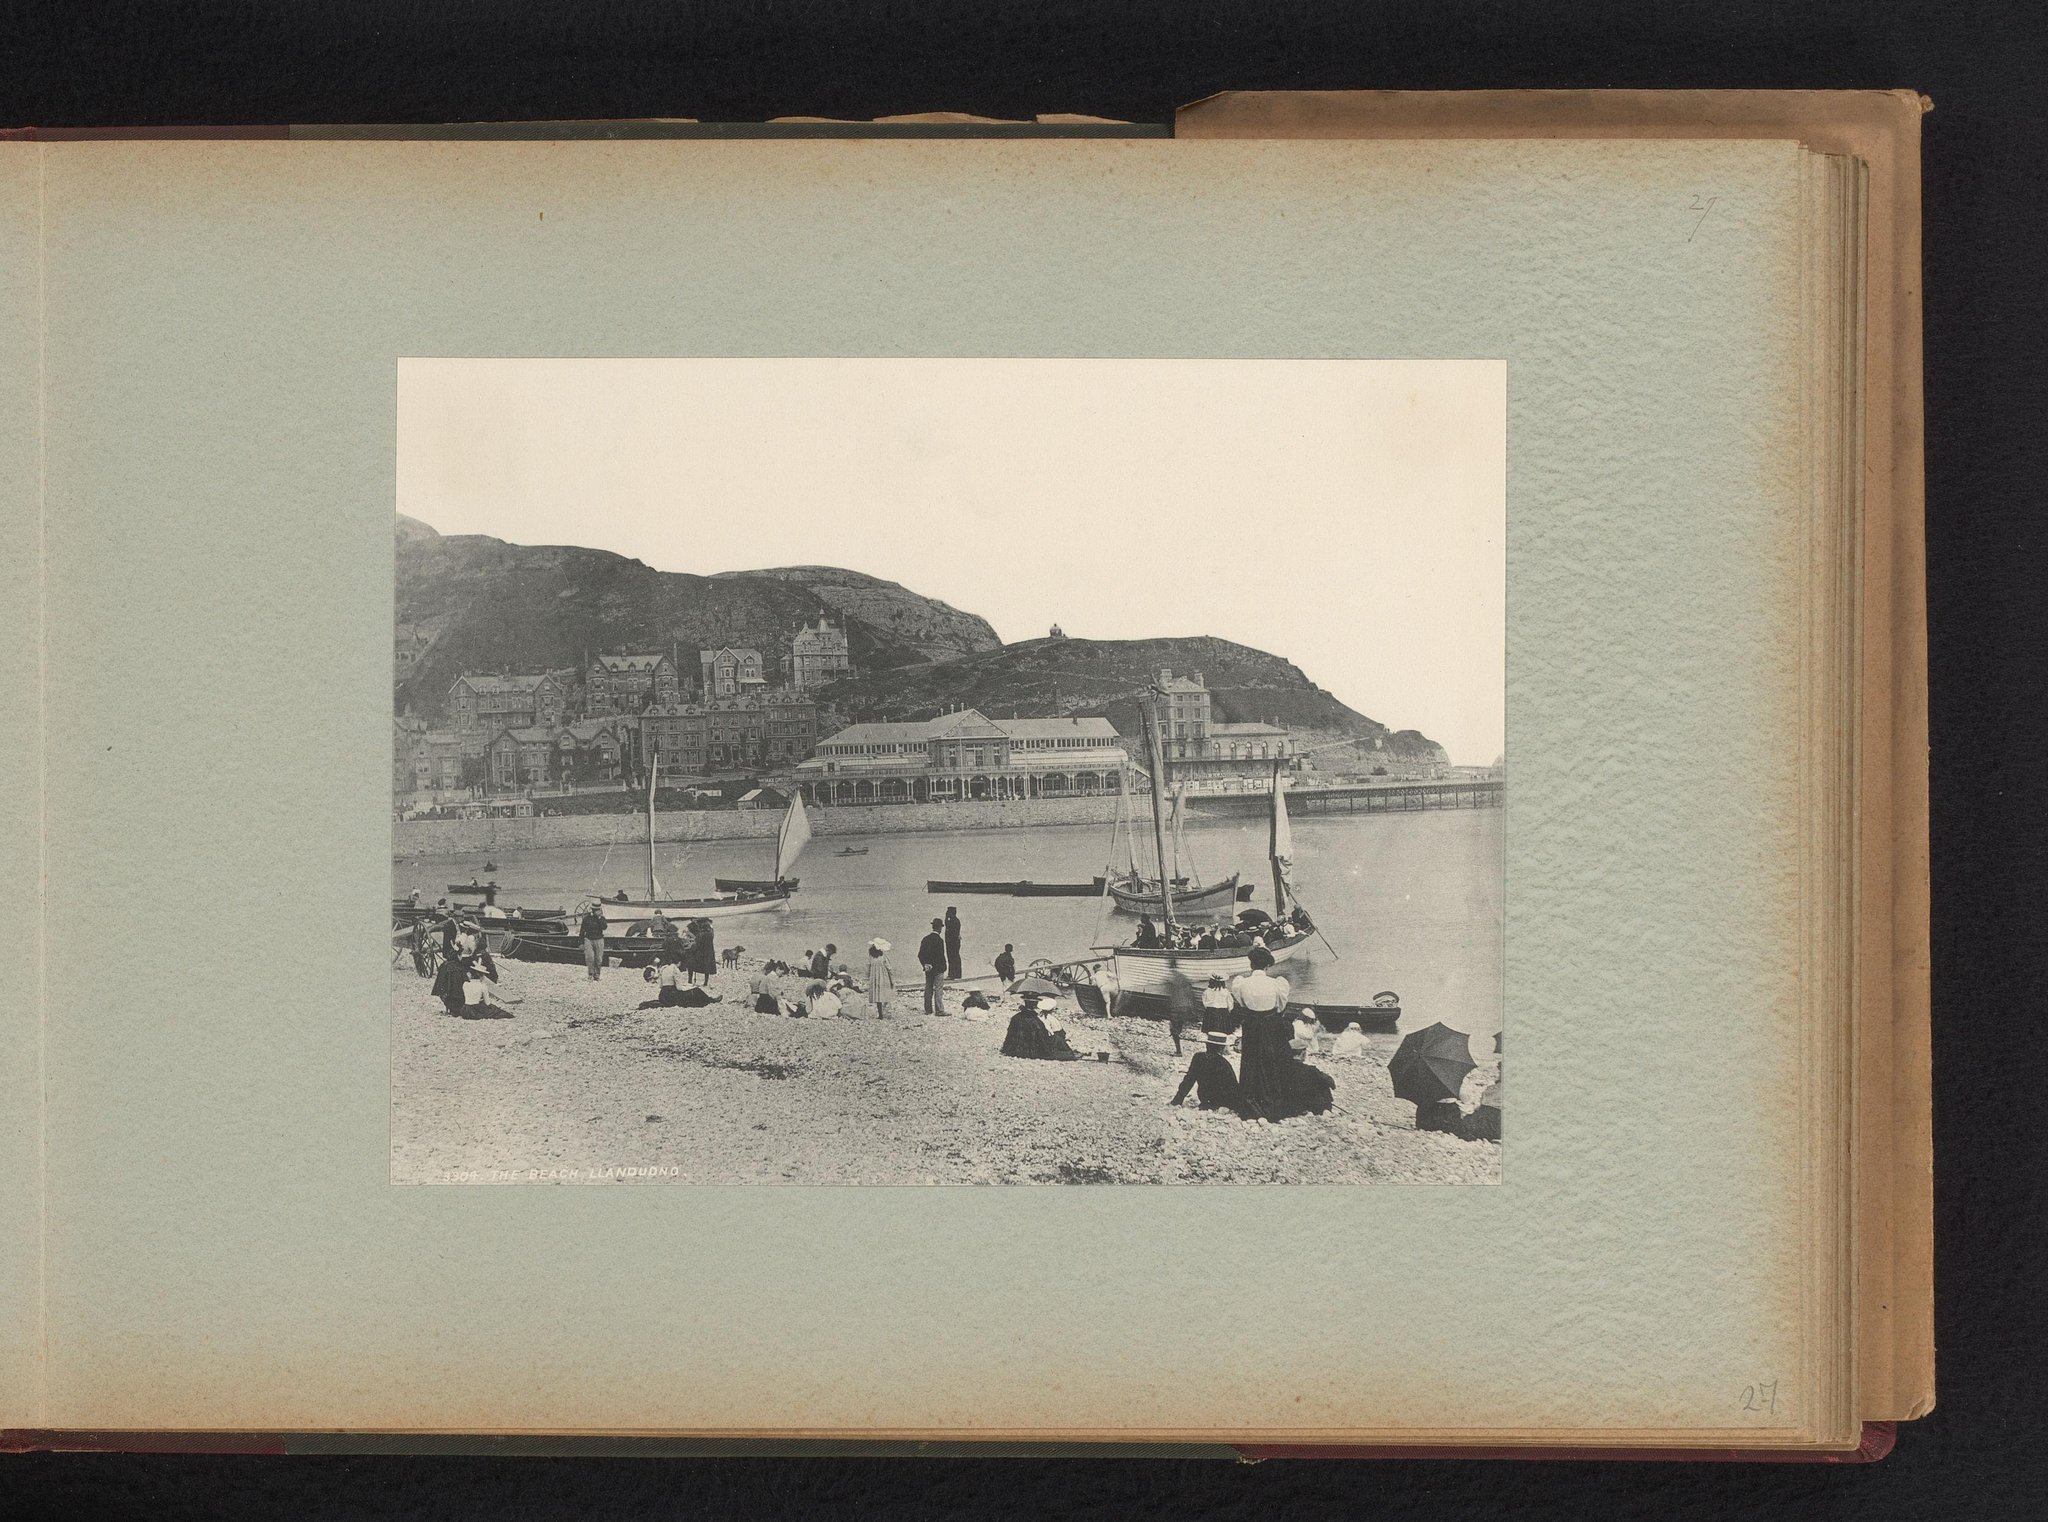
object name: album leaf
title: The Beach. Llandudno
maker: Anonymous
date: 1880-1900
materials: paper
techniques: photograph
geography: llandudno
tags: beach (as place of recreation), prospect of city, town panorama, silhouette of city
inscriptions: number: ‘3304.’, number: ‘27’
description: Deze prent maakt deel uit van een album.